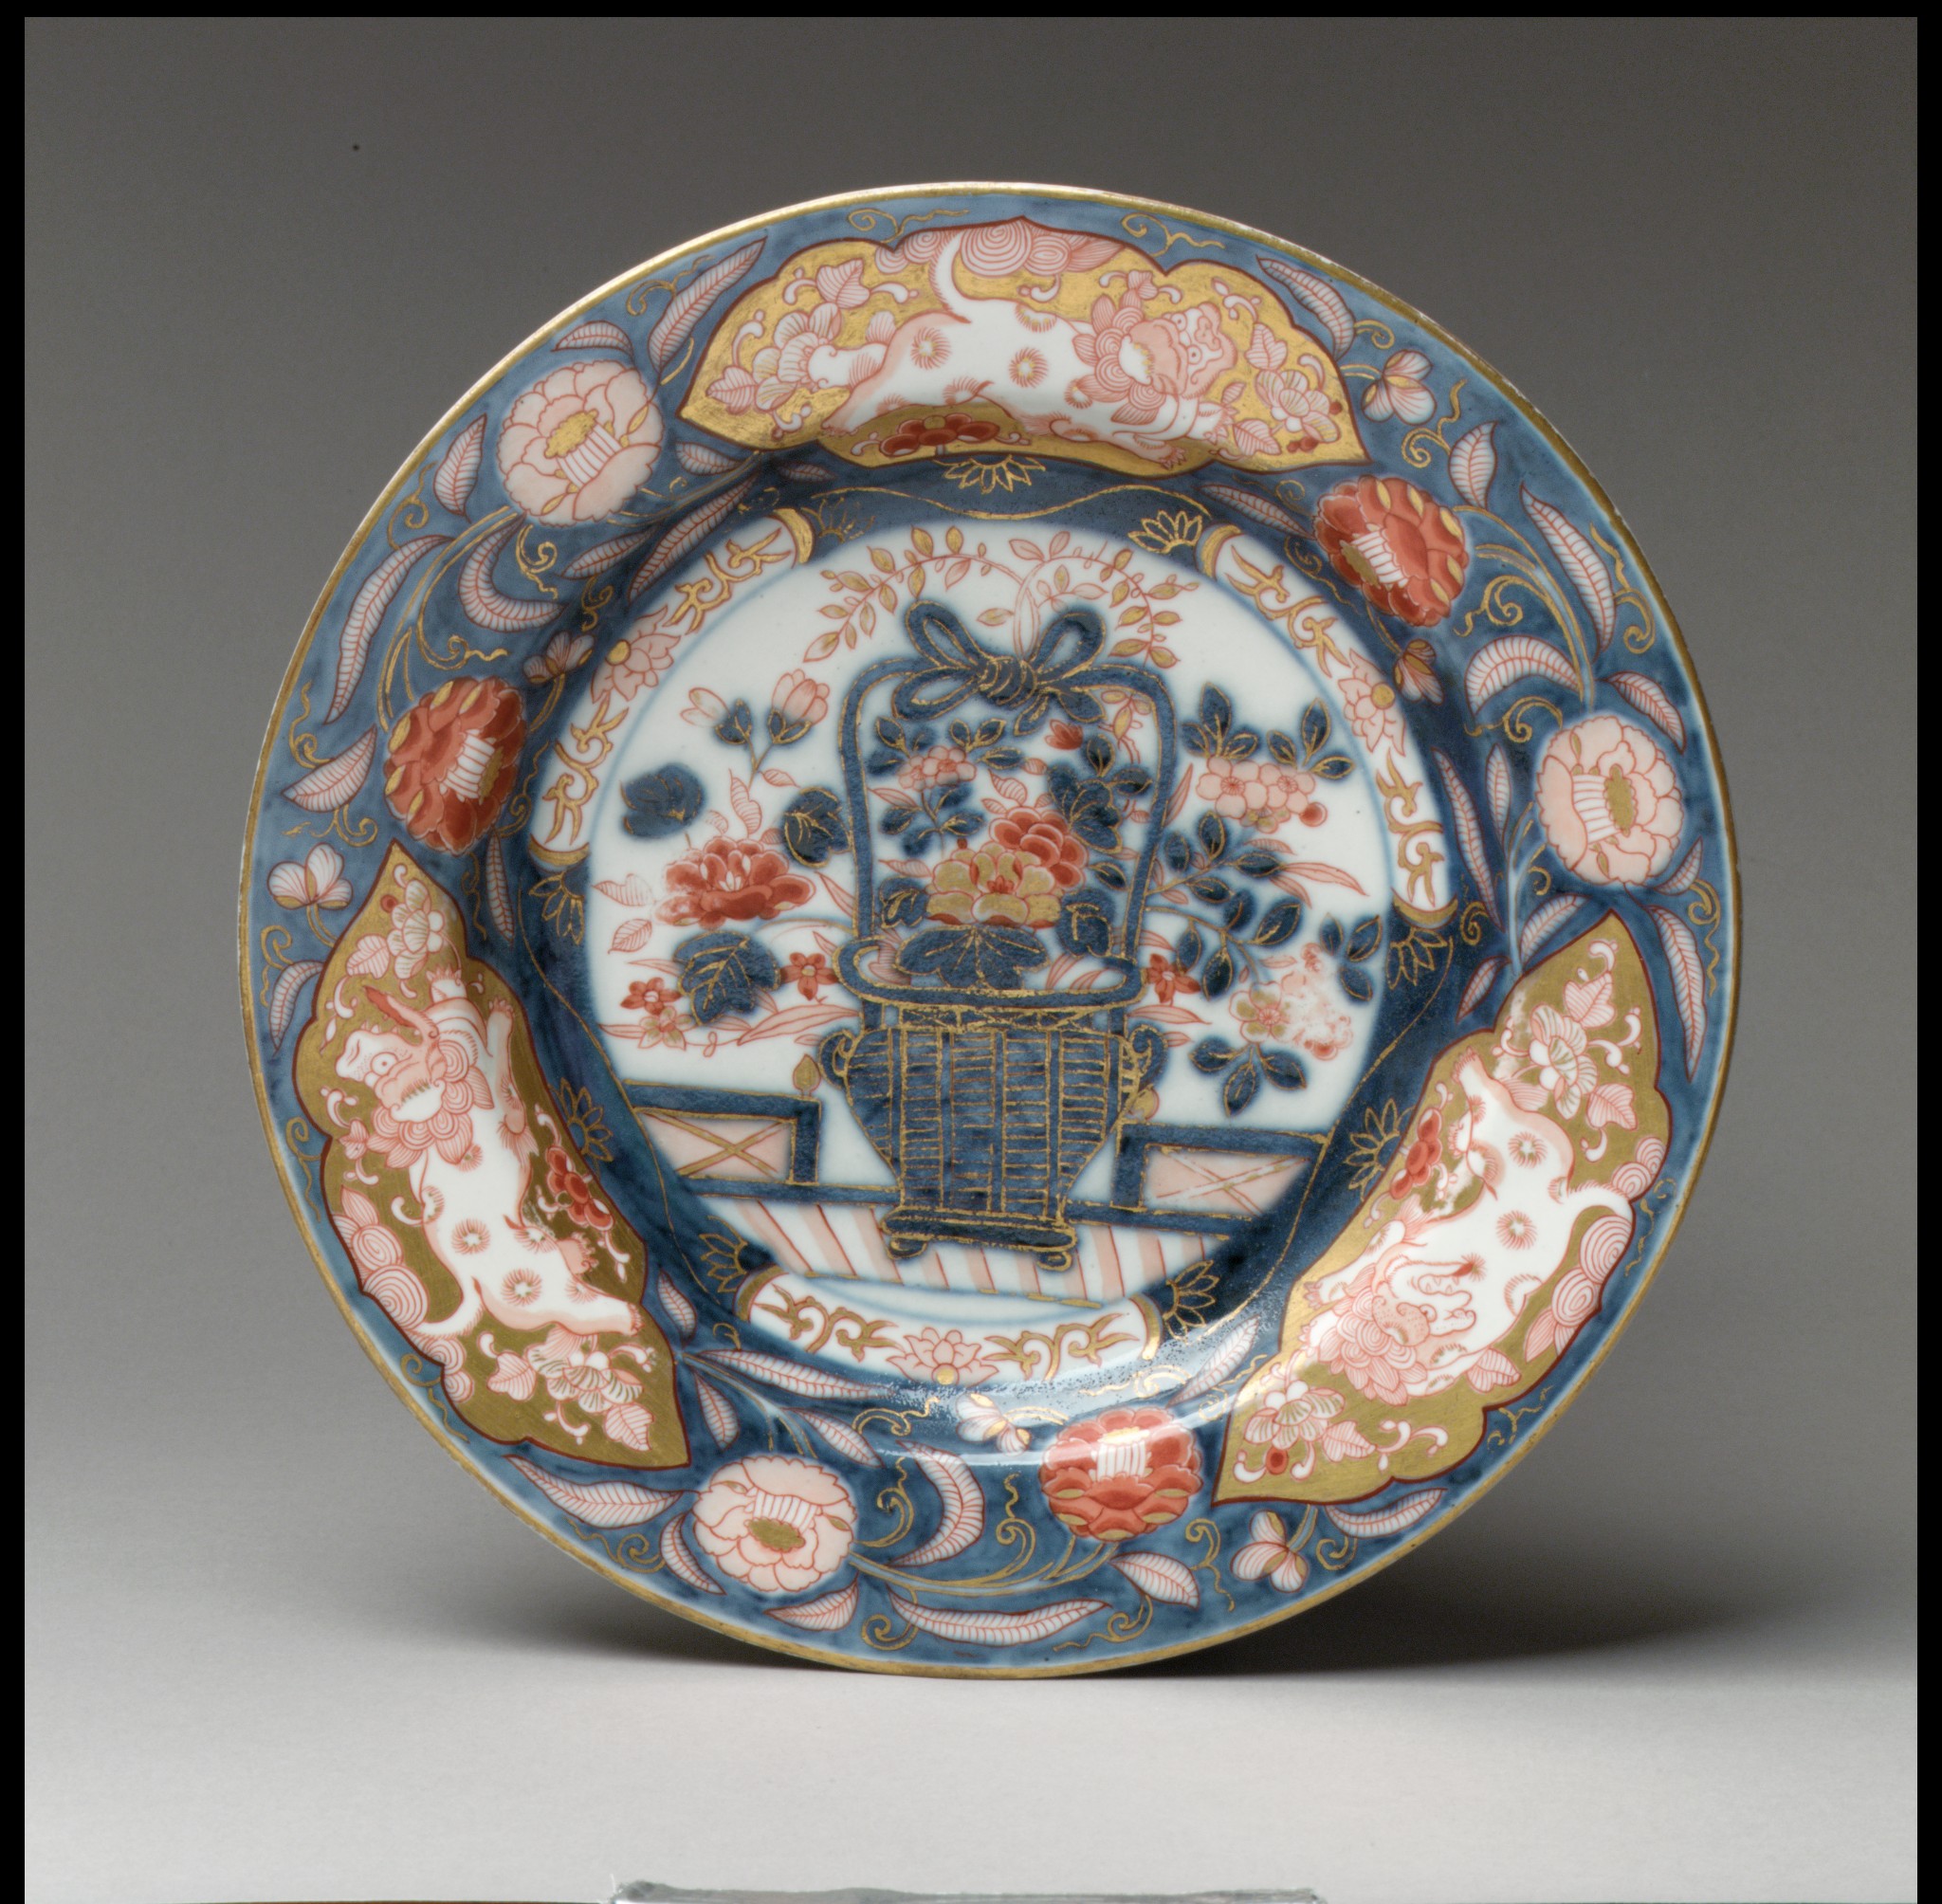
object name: plate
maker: imperial porcelain manufactory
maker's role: manufactory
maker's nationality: austrian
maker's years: 1744-1864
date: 1750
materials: hard paste porcelain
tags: flowers